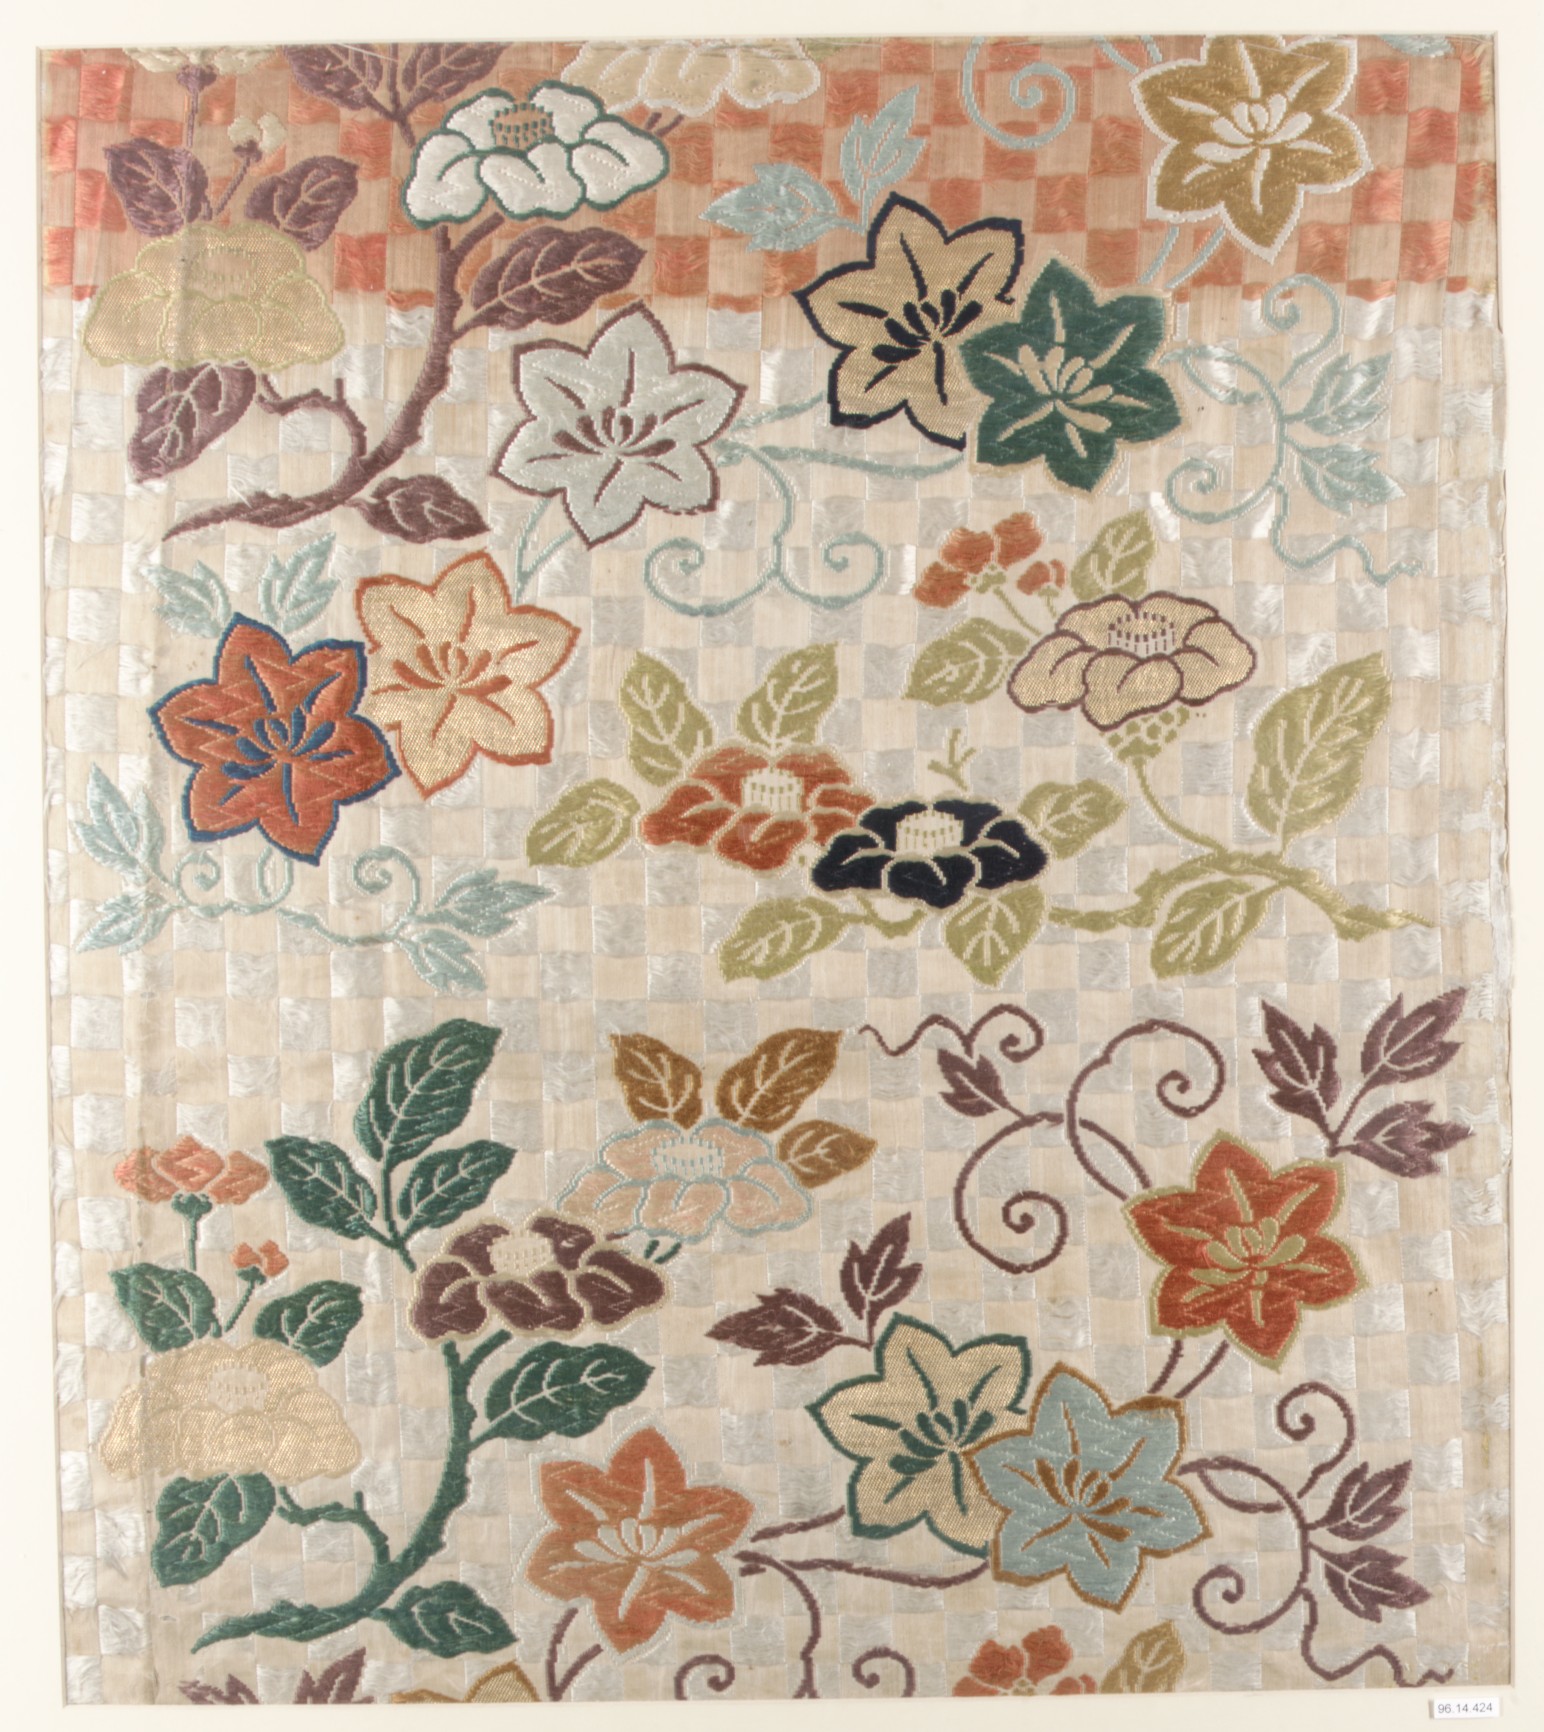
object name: piece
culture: japanese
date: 1701-1800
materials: metal thread, silk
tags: flowers